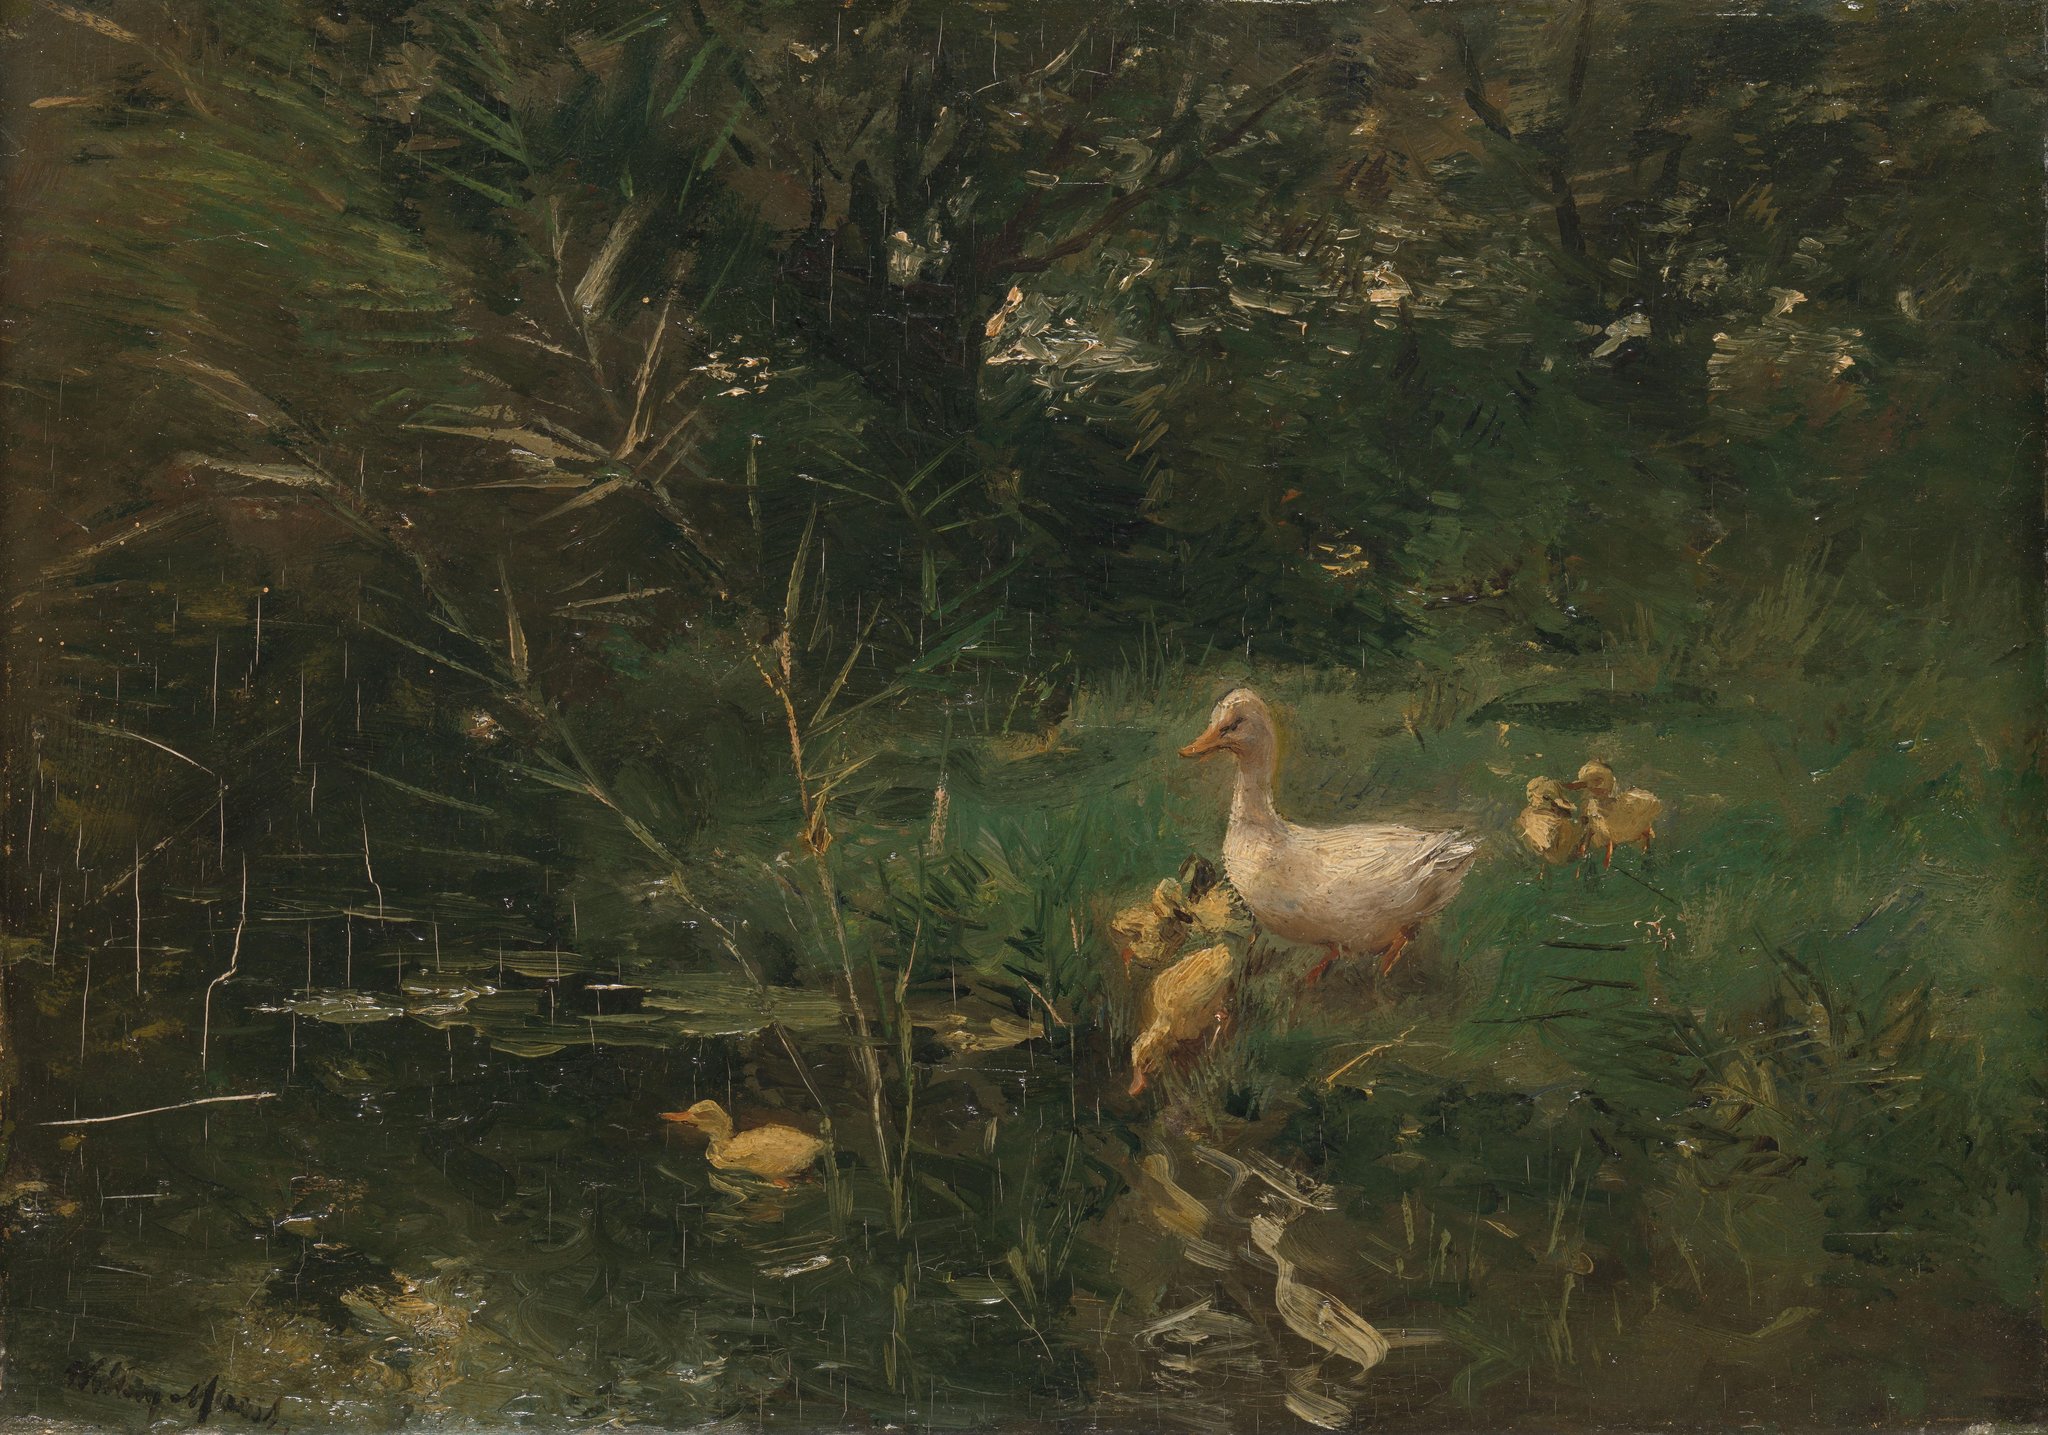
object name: painting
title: Ducks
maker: willem maris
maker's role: draughtsman, painter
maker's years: 1844-1910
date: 1880-1907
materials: oil, panel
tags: water-birds: duck (+ young animal)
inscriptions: signature: ‘Willem Maris’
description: The reeds seem to be rustling here. A mother duck watches her brood splash into the water. Their reflections show on the pond’s surface. Maris used quick strokes of paint to capture the moment. With the invention of the paint tube in 1841, it became much easier for artists, like Maris, to take their materials with them and paint outdoors. He would work upthe compositions back in his studio.